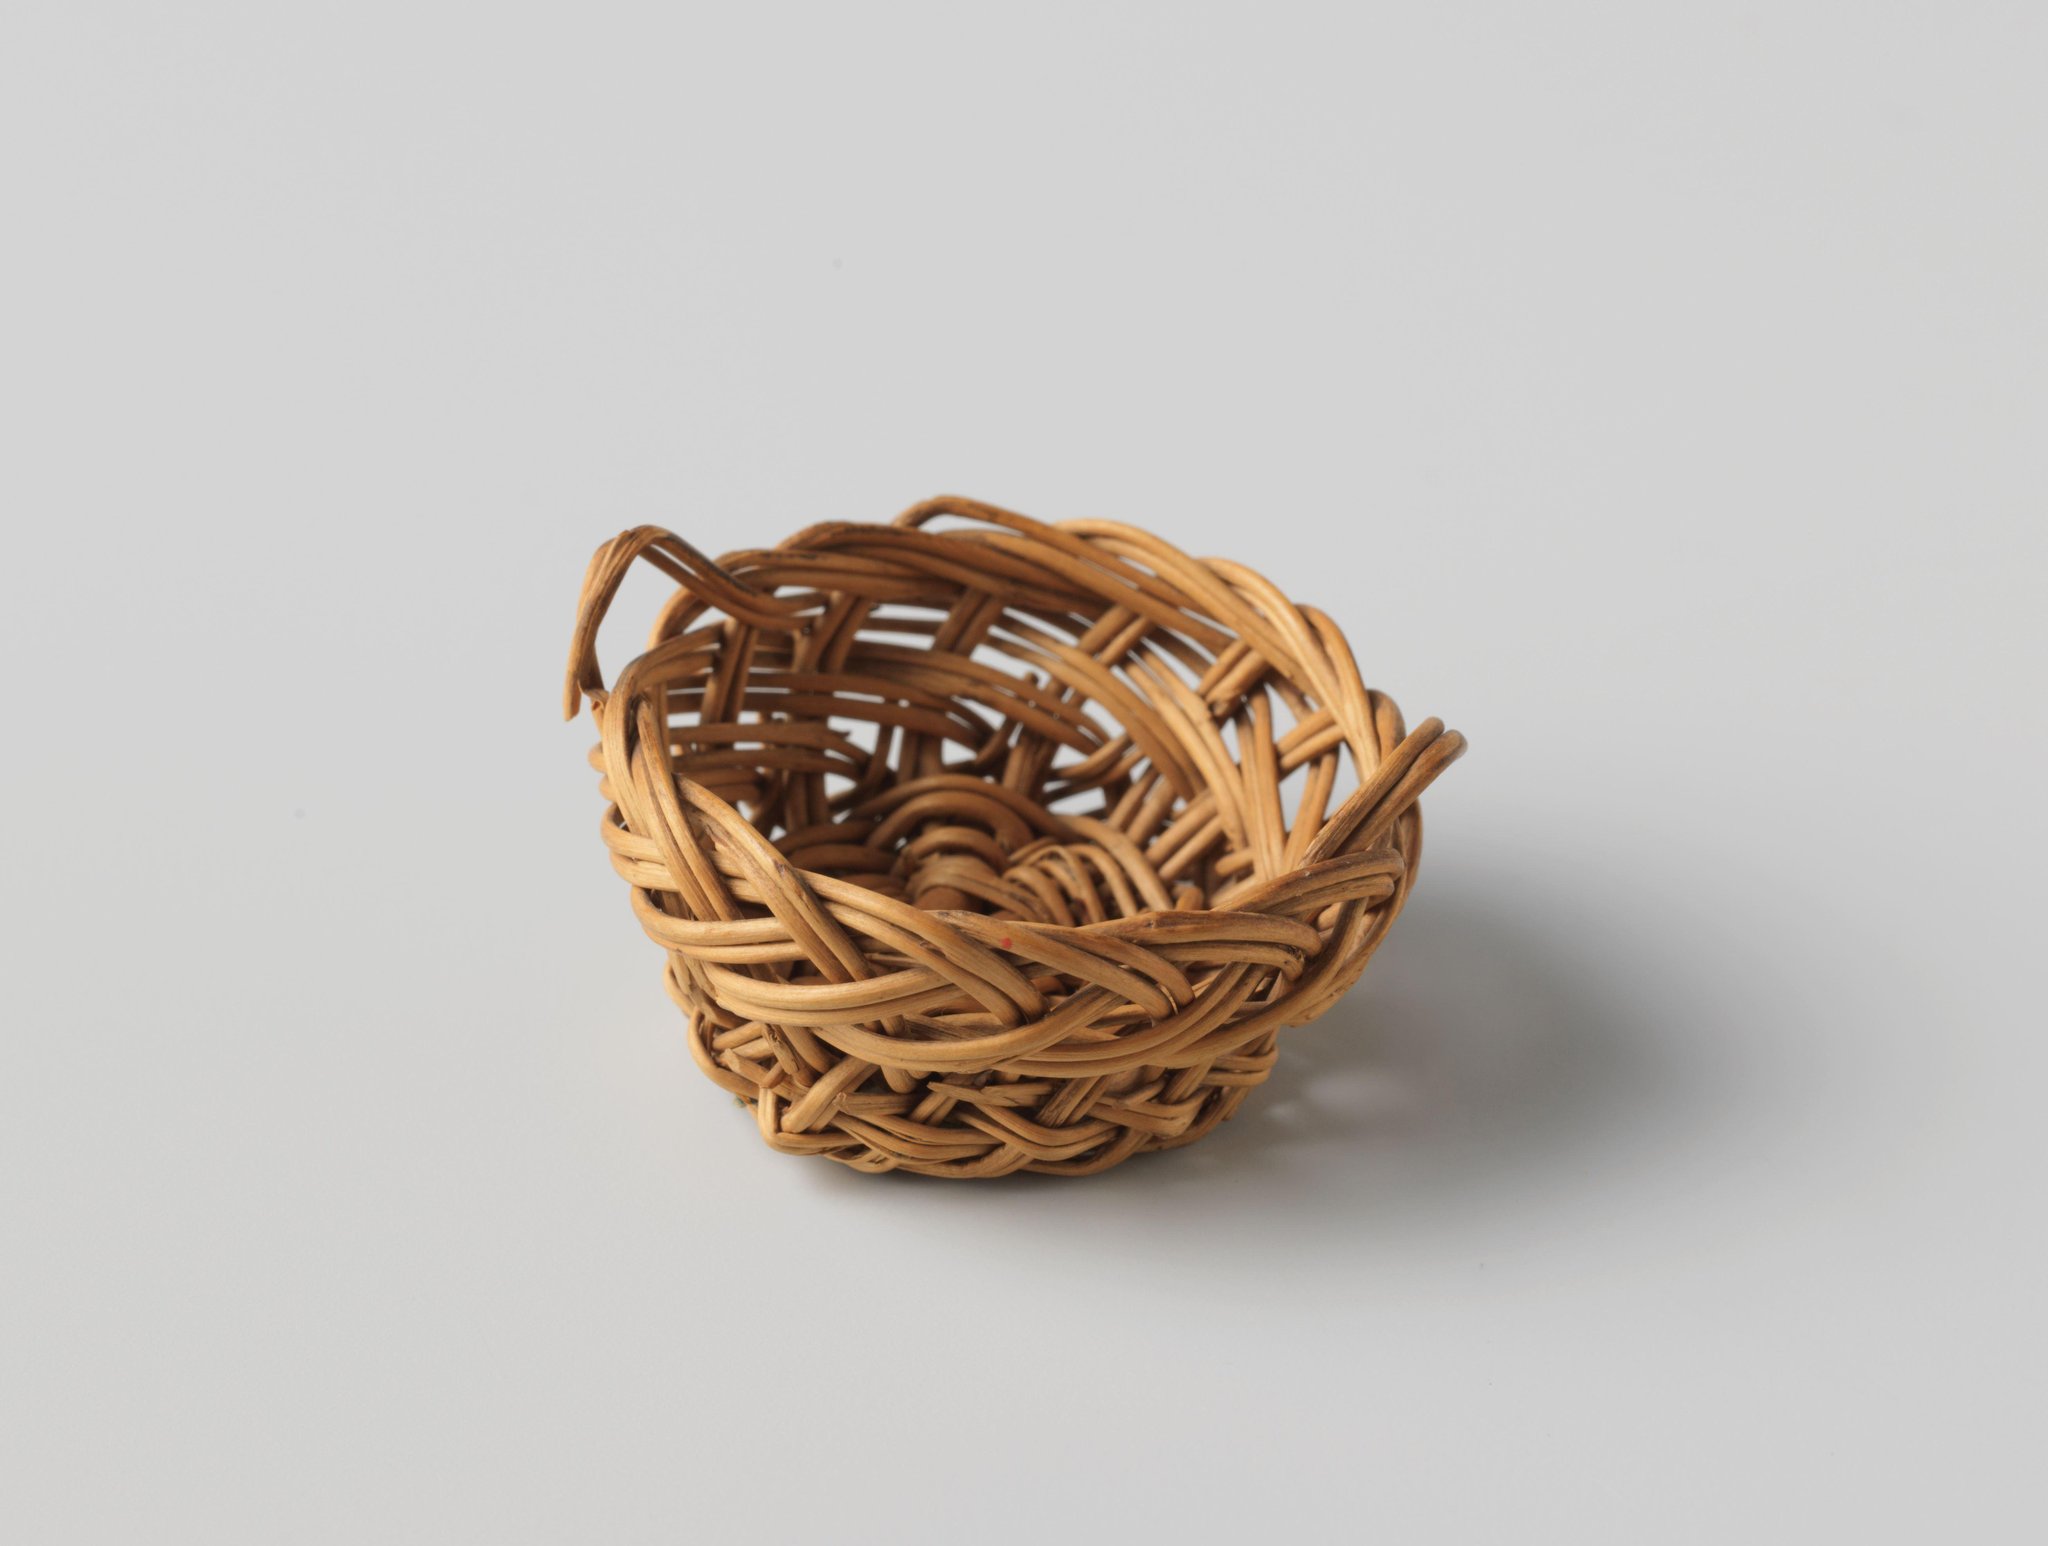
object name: basket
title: Broodmand met twee opstaande handgrepen, gevlochten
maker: Anonymous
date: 1700-1799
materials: plant material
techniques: braiding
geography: netherlands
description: Broodmand van gevlochten wilgenteen met twee opstaande handgrepen.